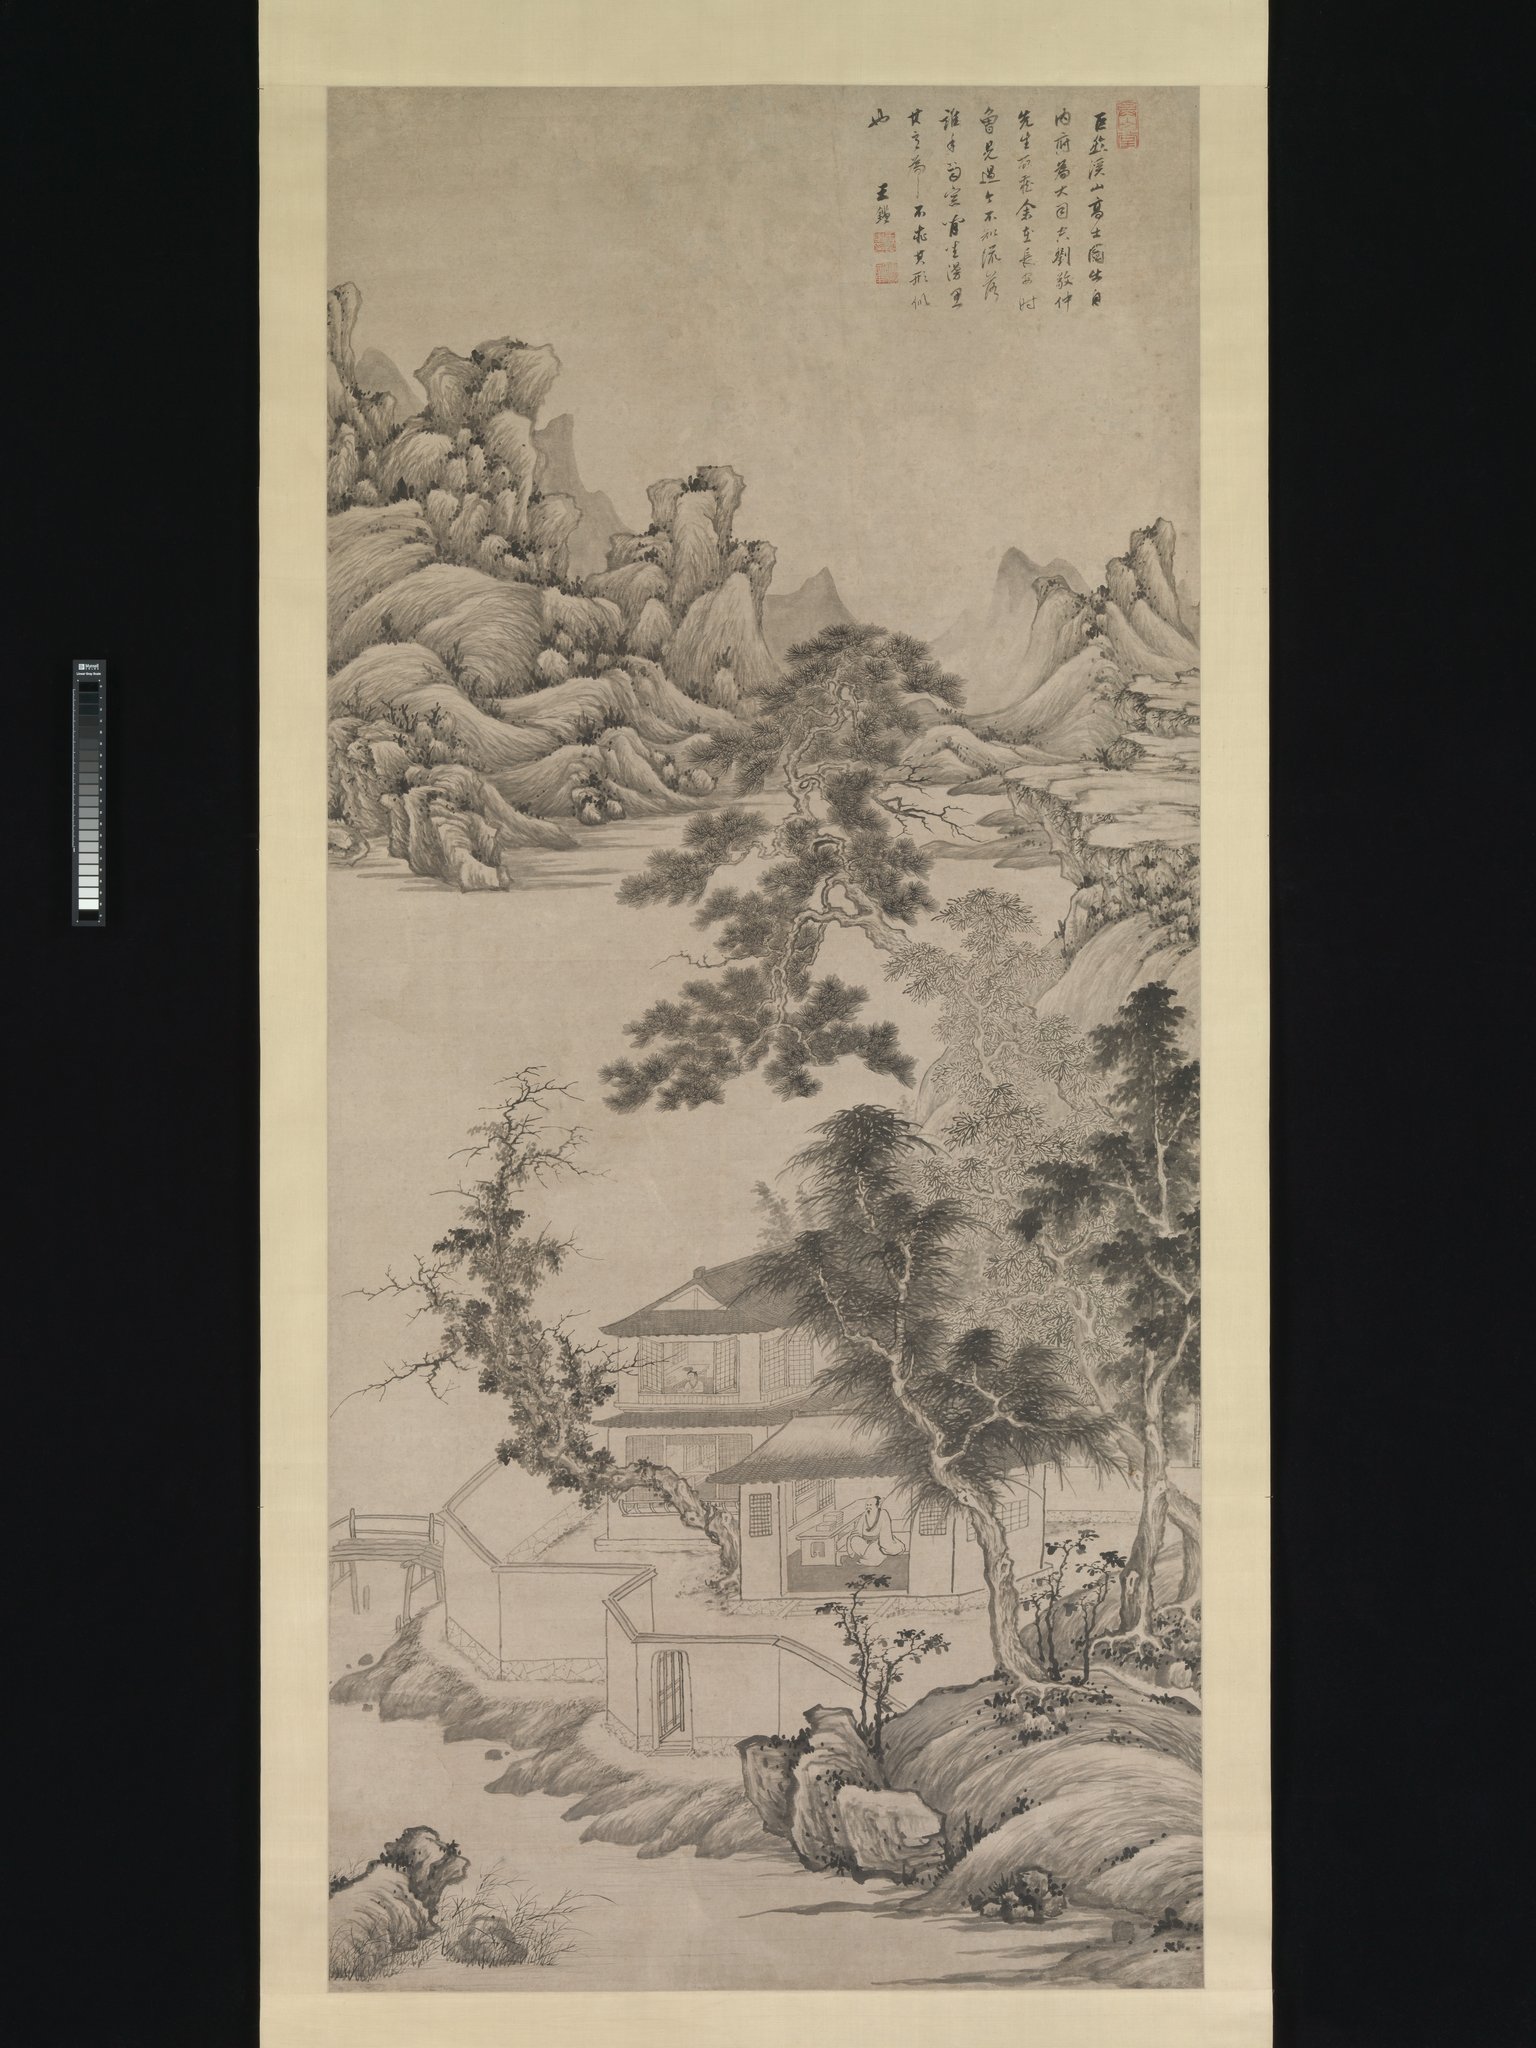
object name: hanging scroll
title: Lofty Scholar among Streams and Mountains, in the manner of Juran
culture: chinese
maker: wang jian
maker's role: artist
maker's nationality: chinese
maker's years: 1609-1677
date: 1667-1700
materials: ink, paper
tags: mountains,landscapes,pavilions